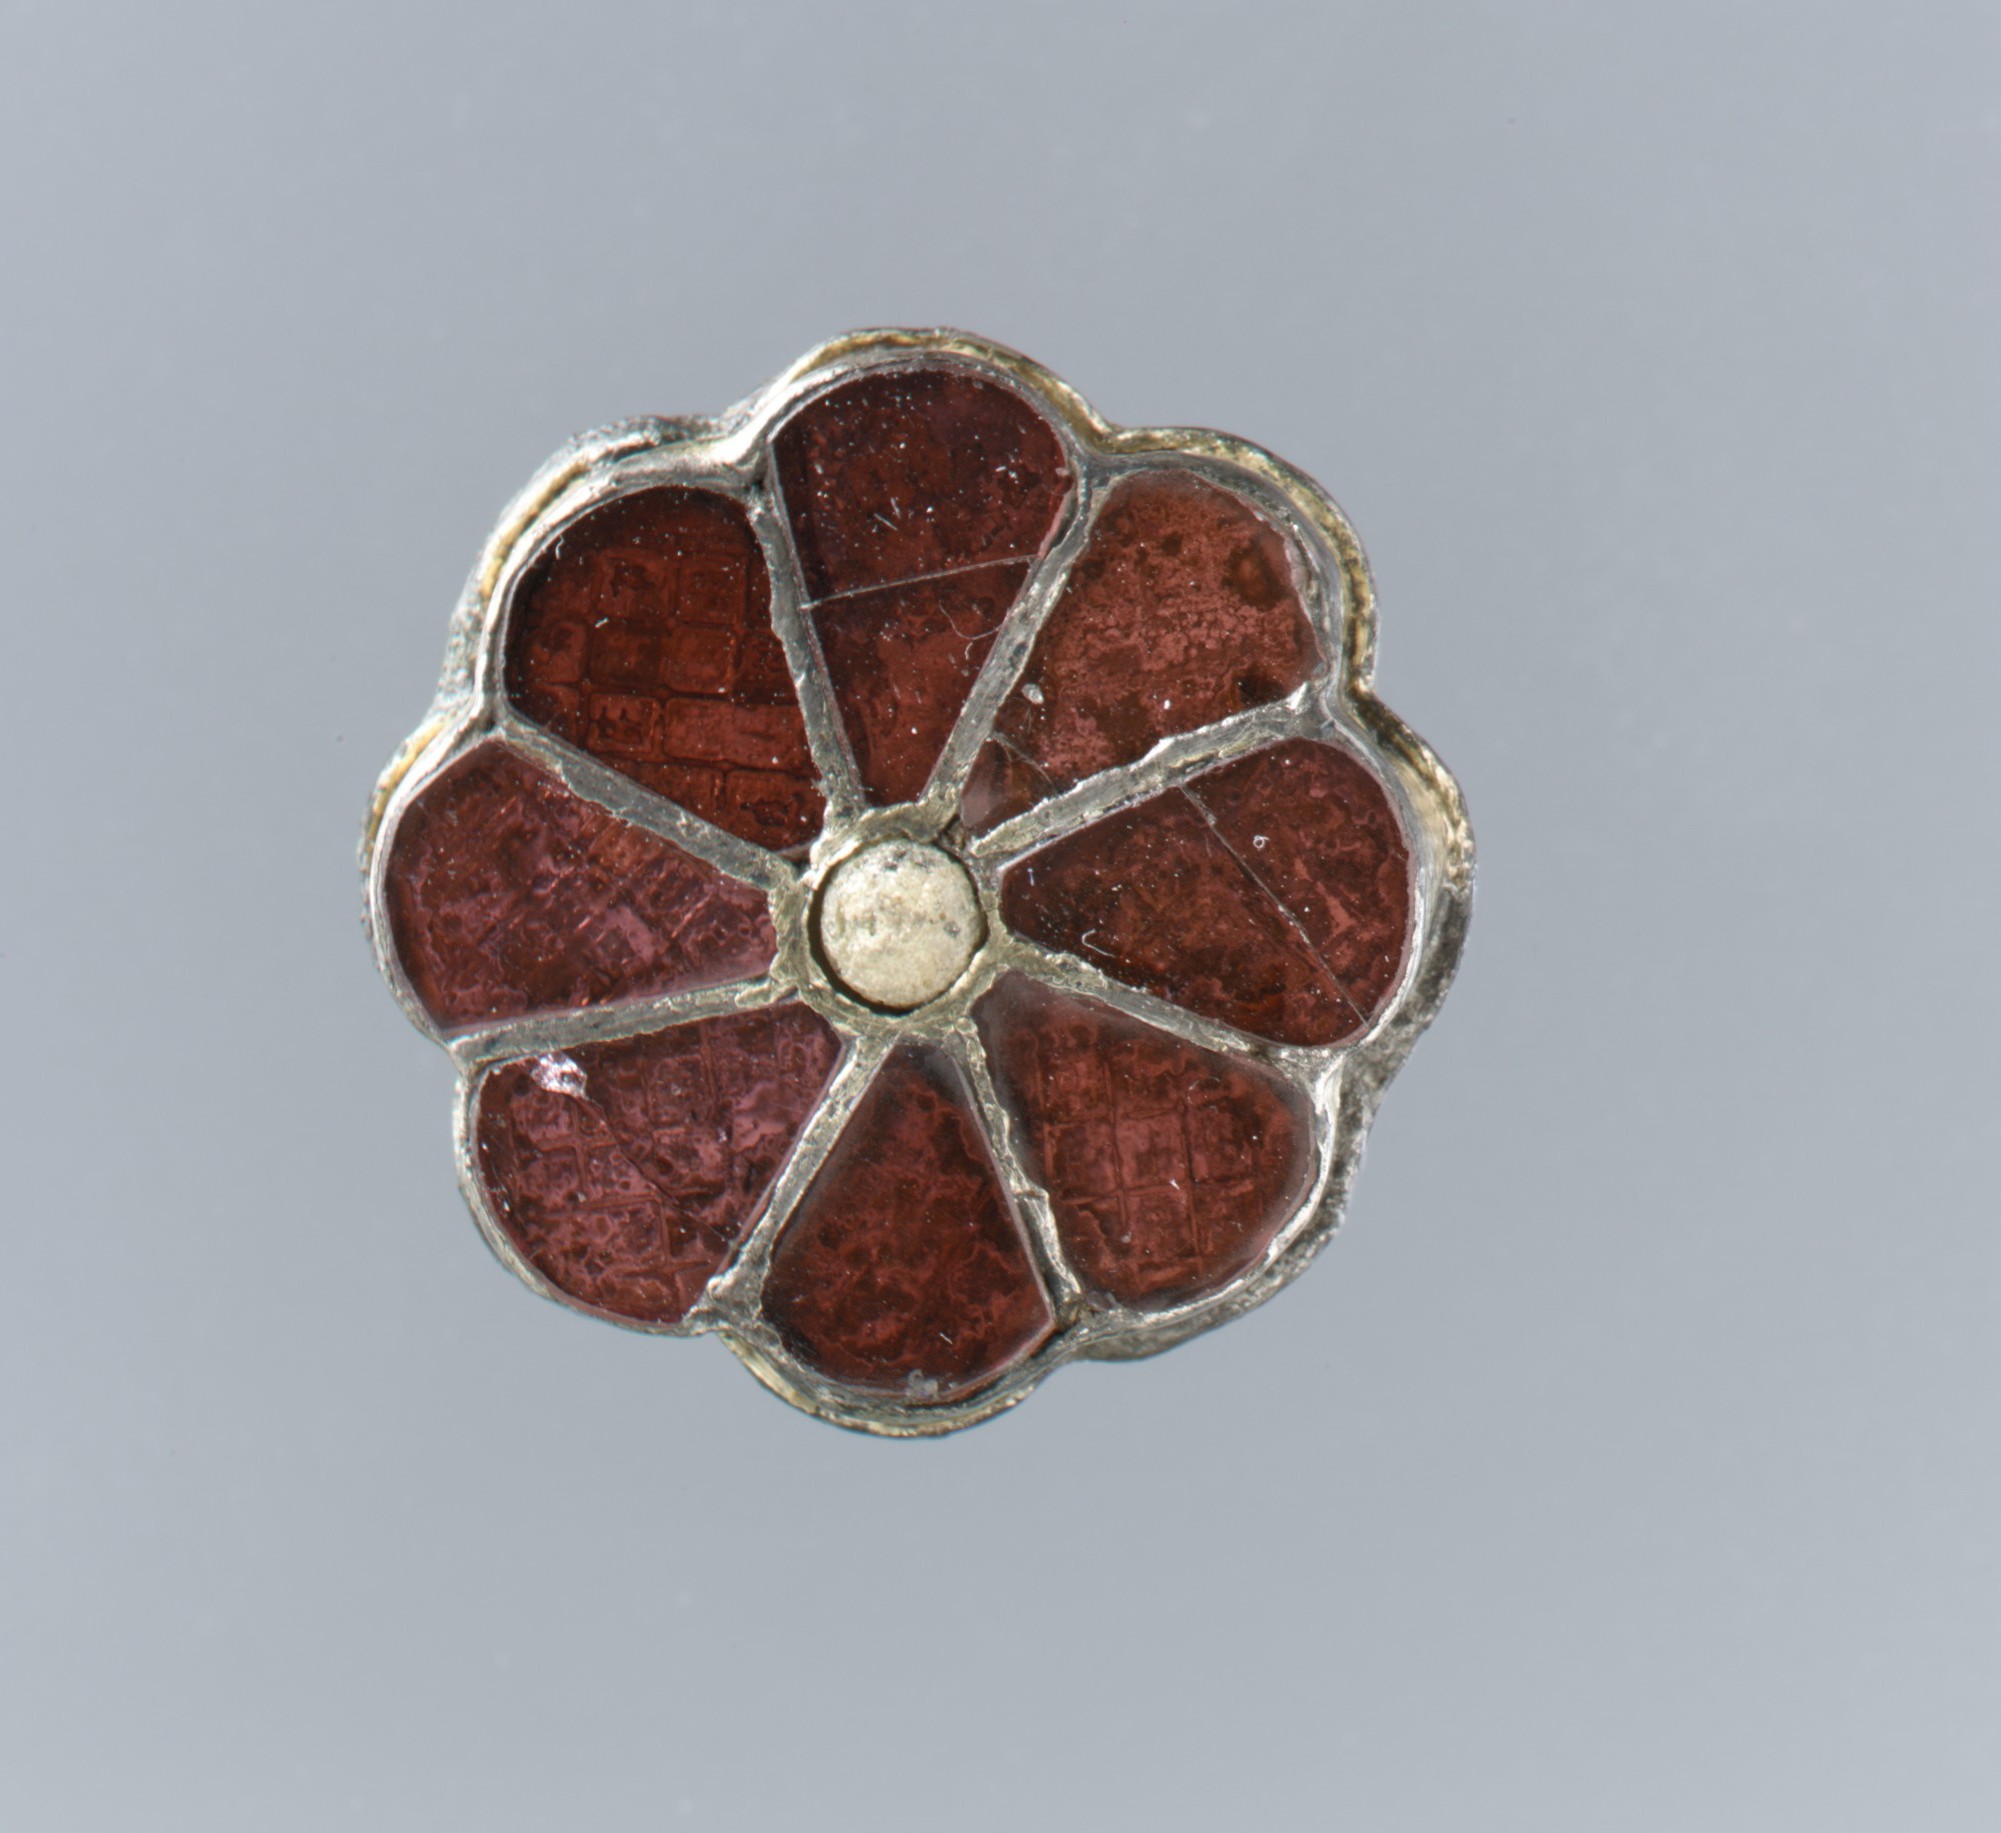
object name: brooch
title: Rosette Brooch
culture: frankish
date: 501-600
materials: foil, garnet, silver gilt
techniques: filigree